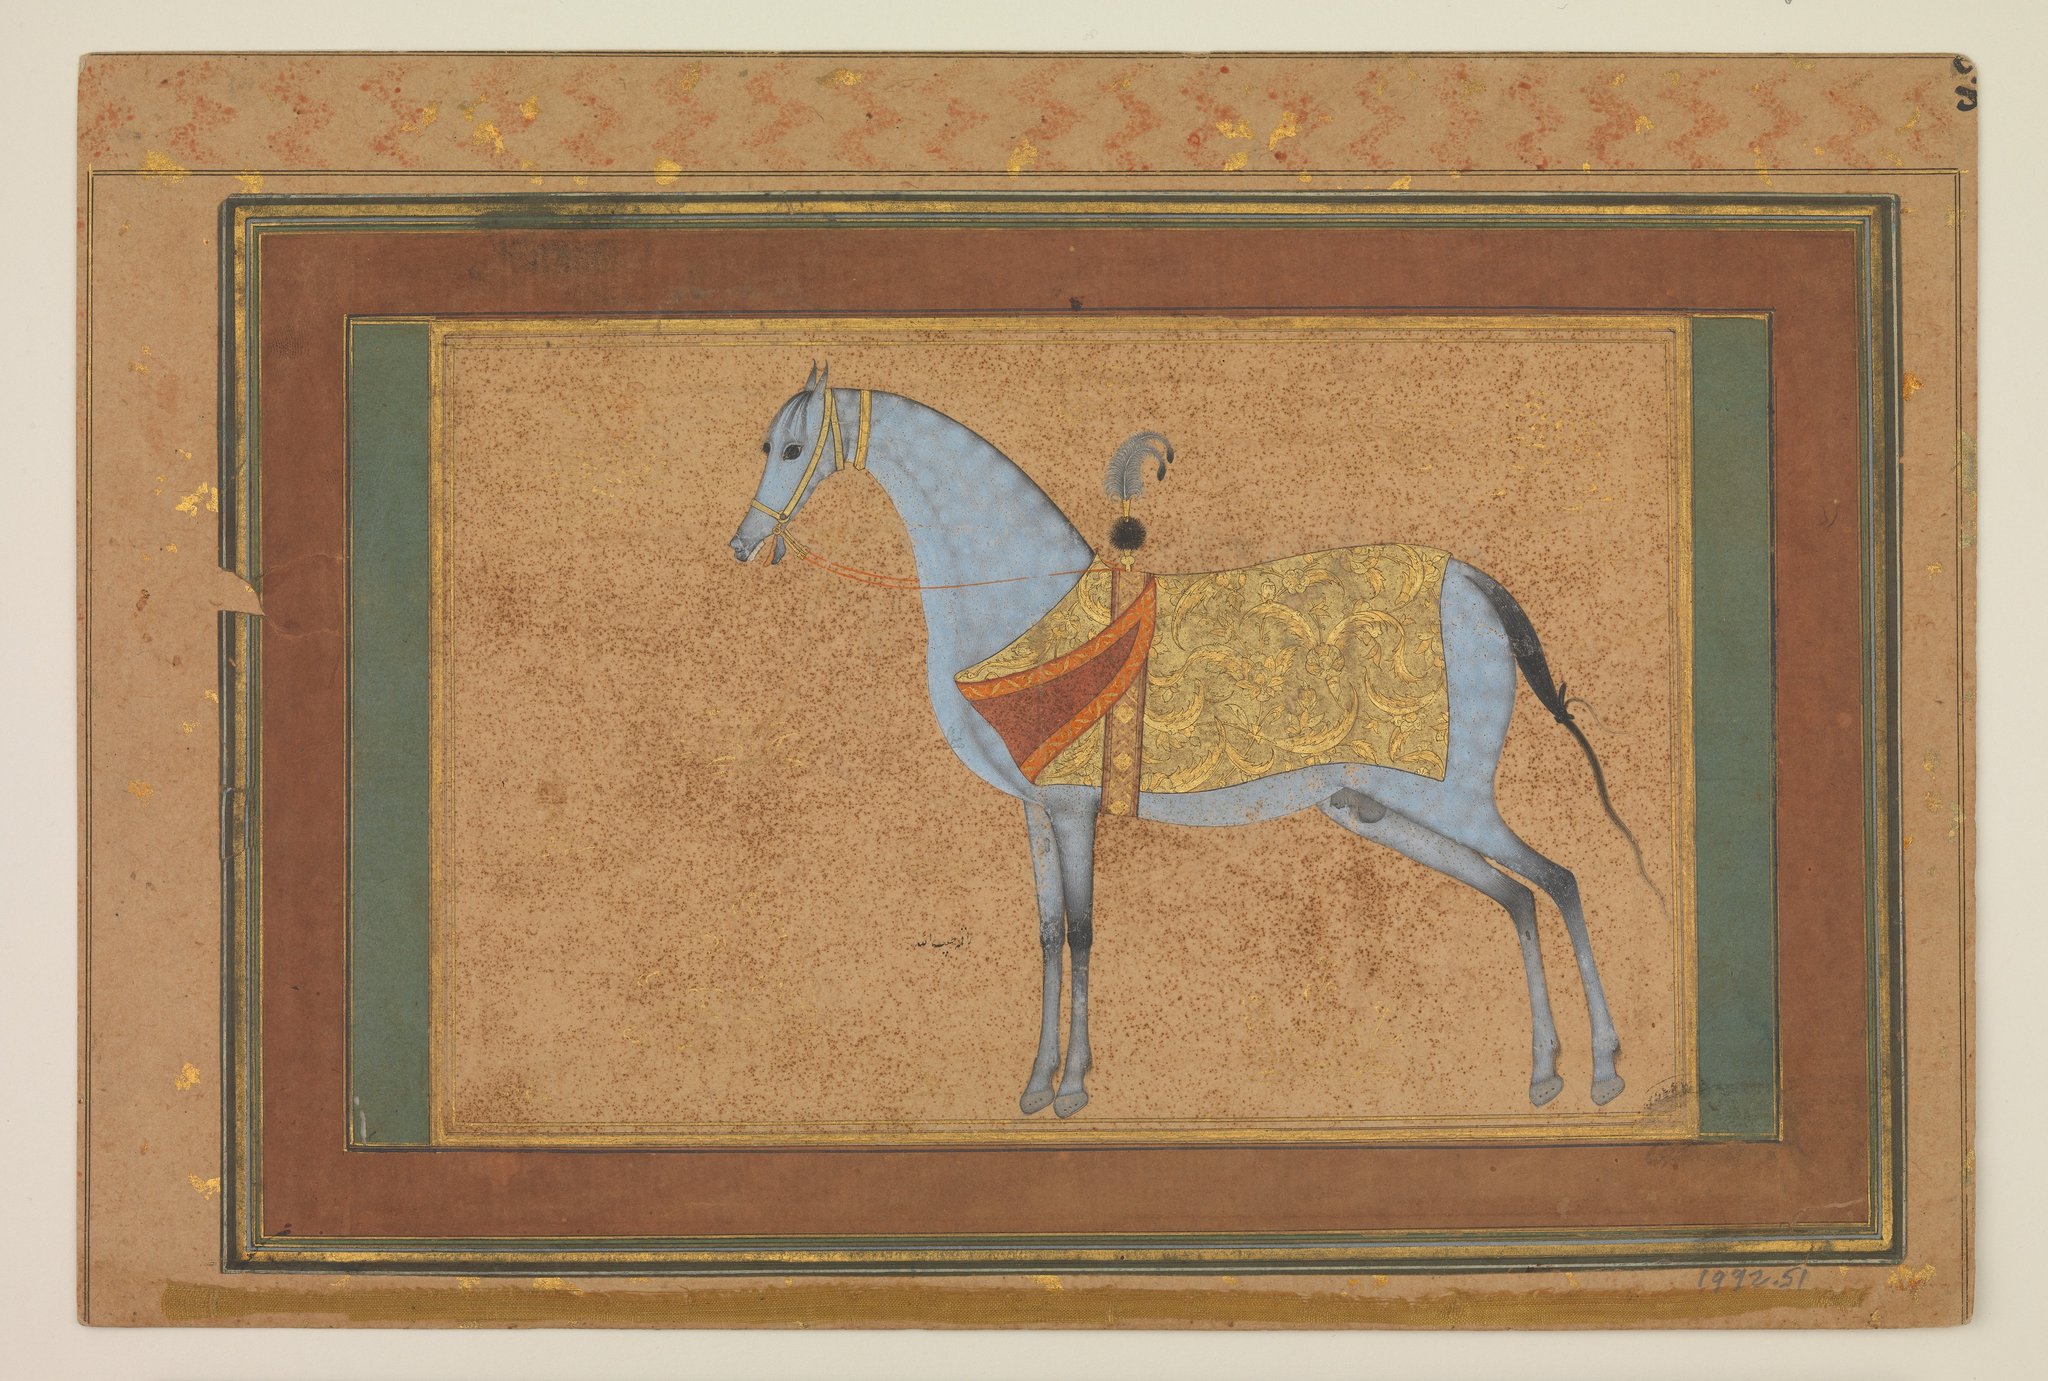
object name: illustrated album leaf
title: A Stallion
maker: habiballah of sava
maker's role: artist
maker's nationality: iranian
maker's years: 1565-1635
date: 1601-1606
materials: gold, ink, paper, watercolor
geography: afghanistan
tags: horses